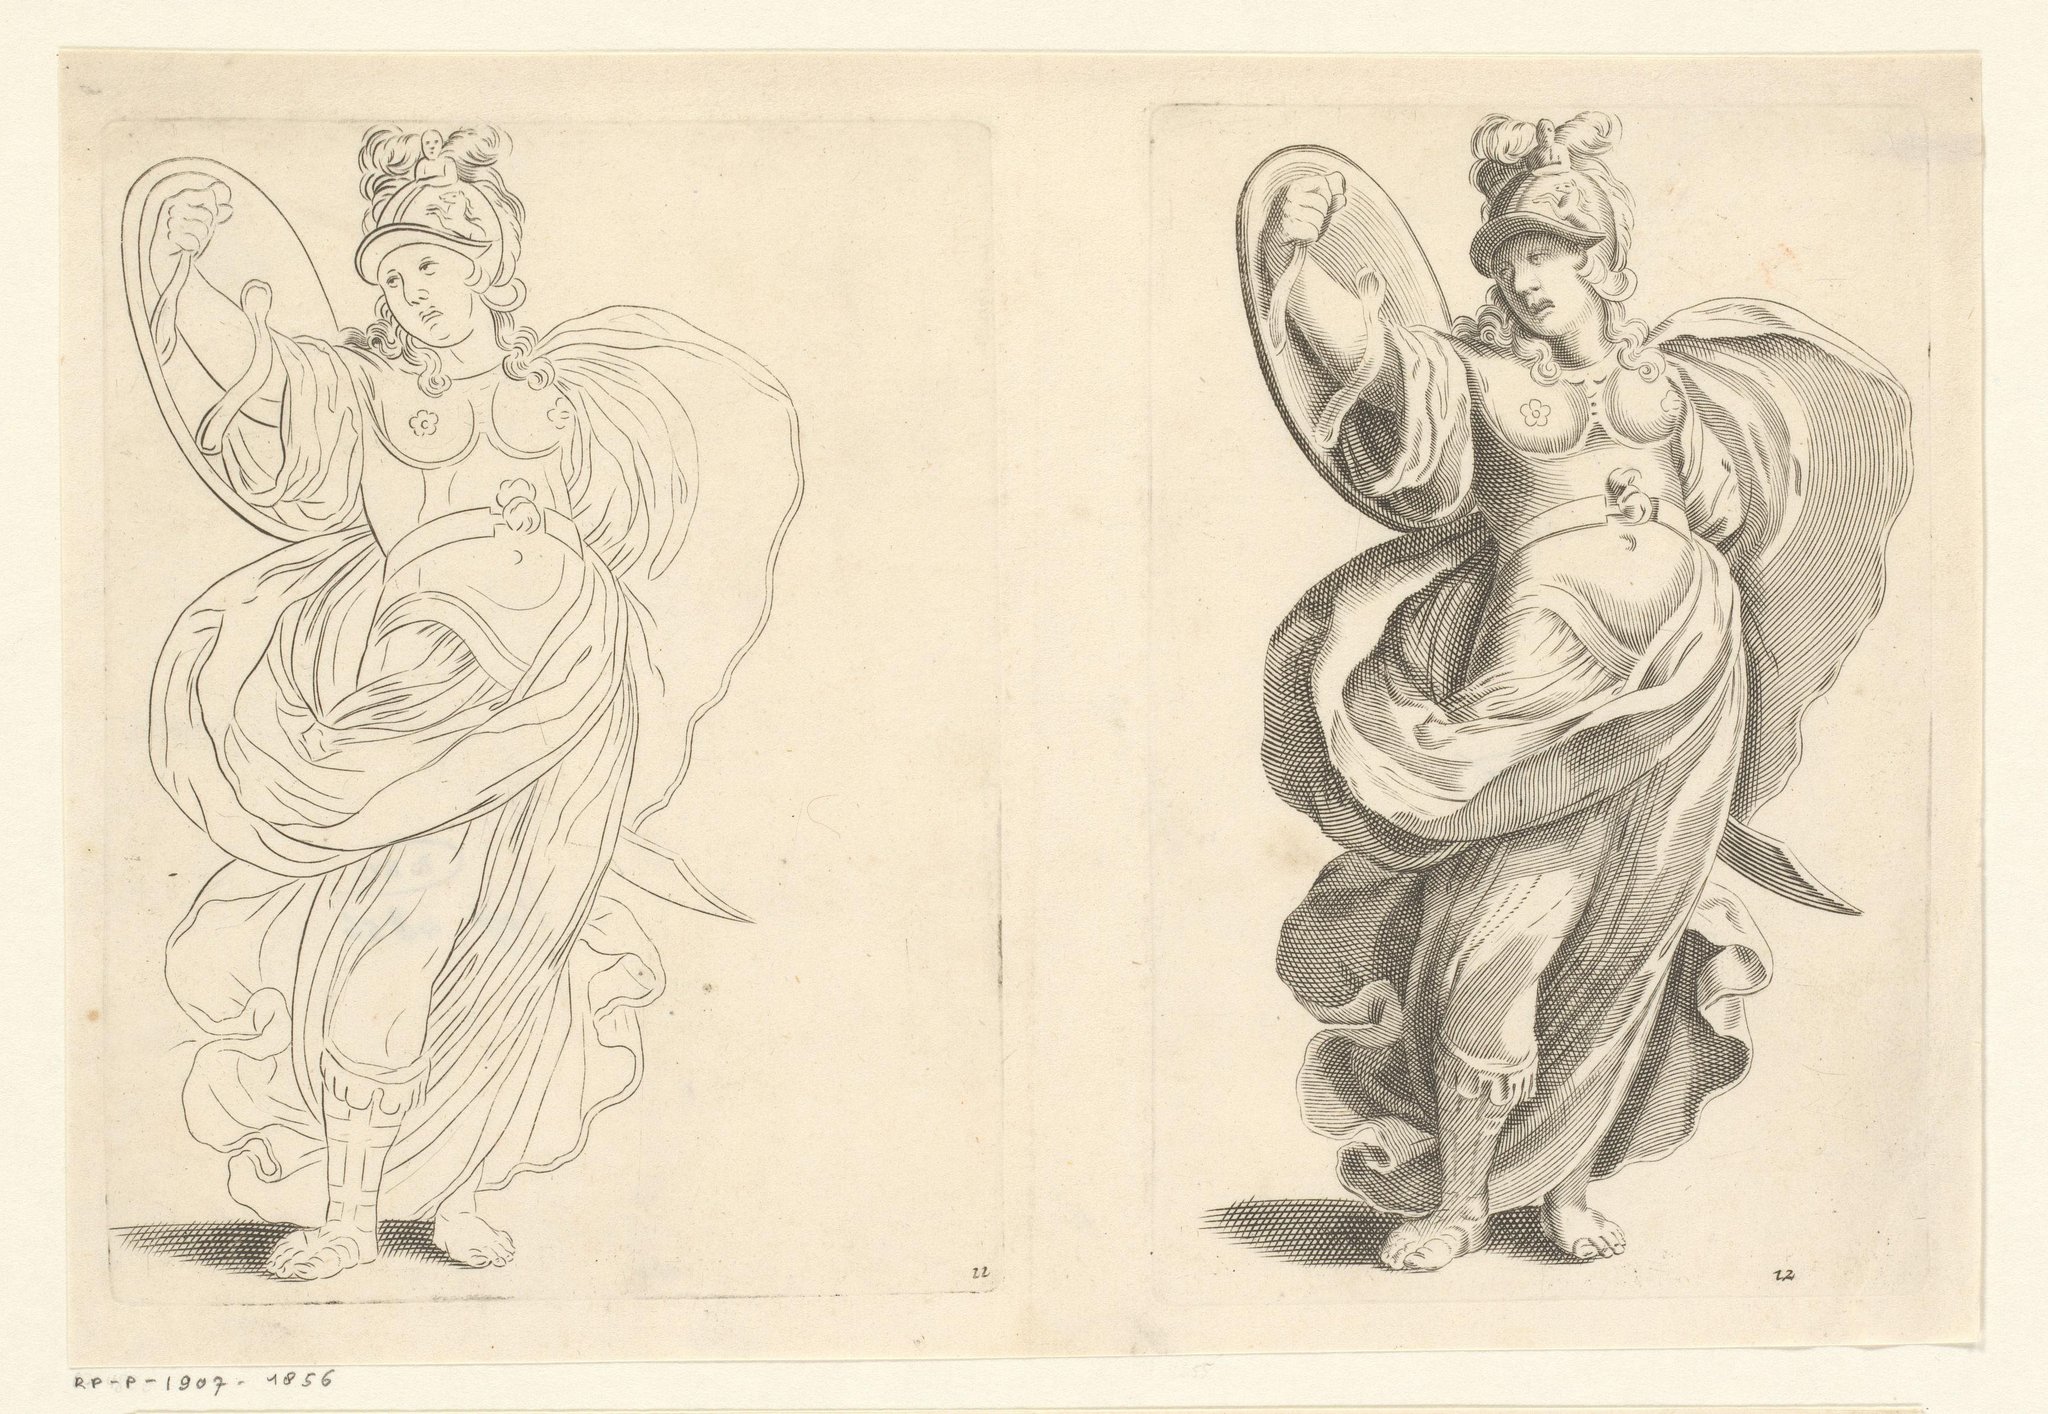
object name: print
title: Picturae rudimenta Lairessiana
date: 1702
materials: paper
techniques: engraving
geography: amsterdam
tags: protective weapons: shield, (story of) minerva (pallas, athena)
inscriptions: collector's mark: Lugt 2228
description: Deze prent is gebruikt als illustratie in: Lairesse, Gérard de. Picturae rudimenta Lairessiana. Amsterdam: Pieter Schenk (I), 1702.